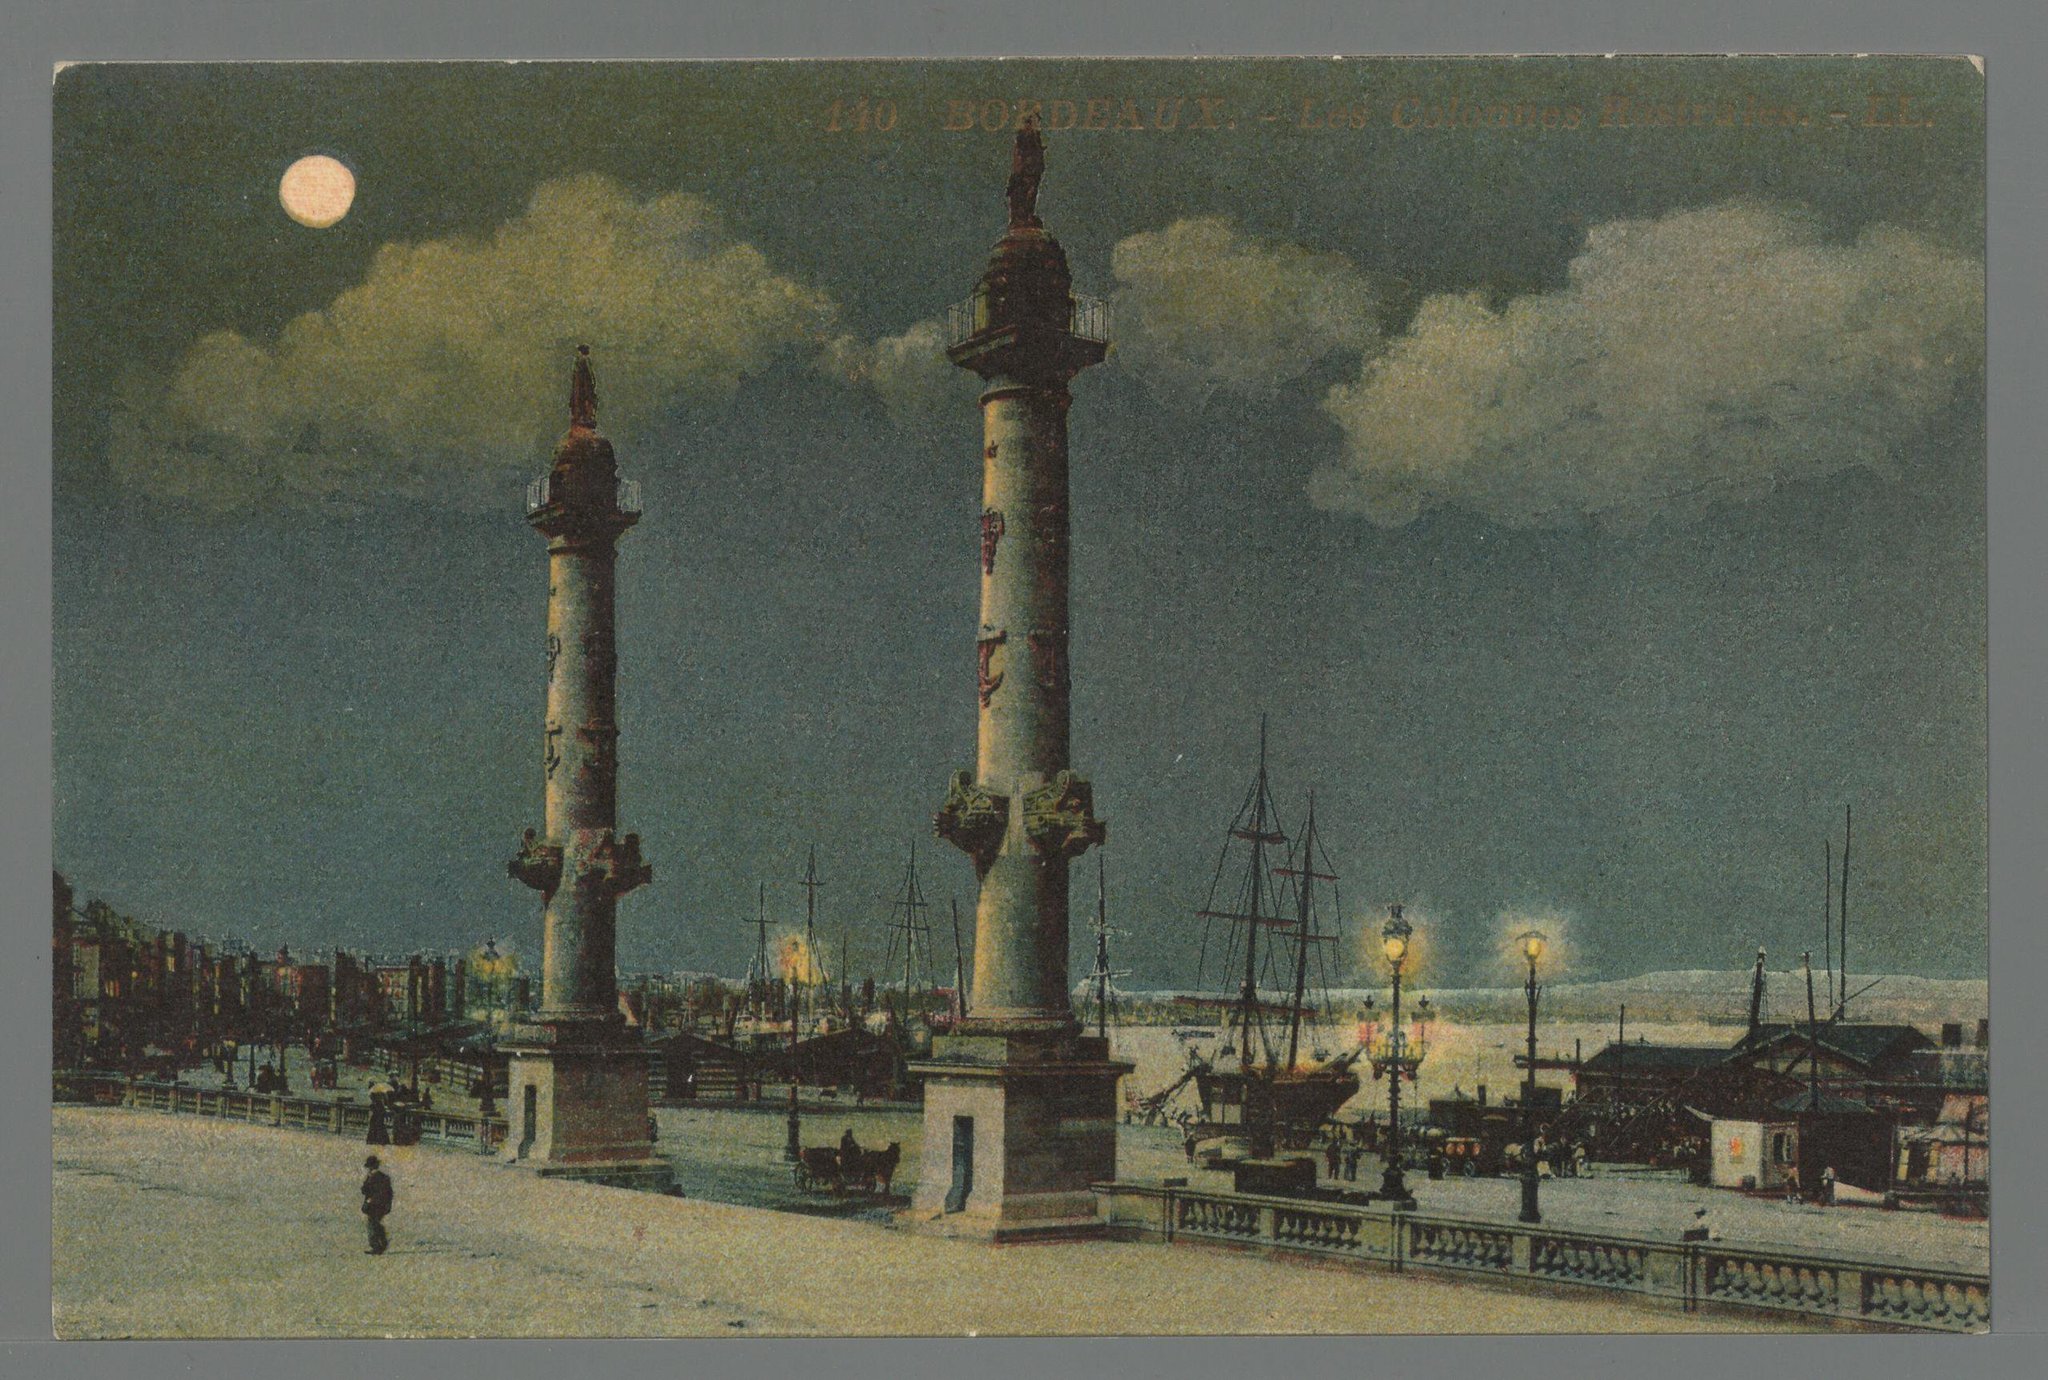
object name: photomechanical print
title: Bordeaux. Les Colonnes Rostrales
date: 1903-1920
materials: cardboard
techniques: photograph, lithograph, writing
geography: paris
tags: harbour, full moon, monument, statue (+ city(-scape) with figures, staffage)